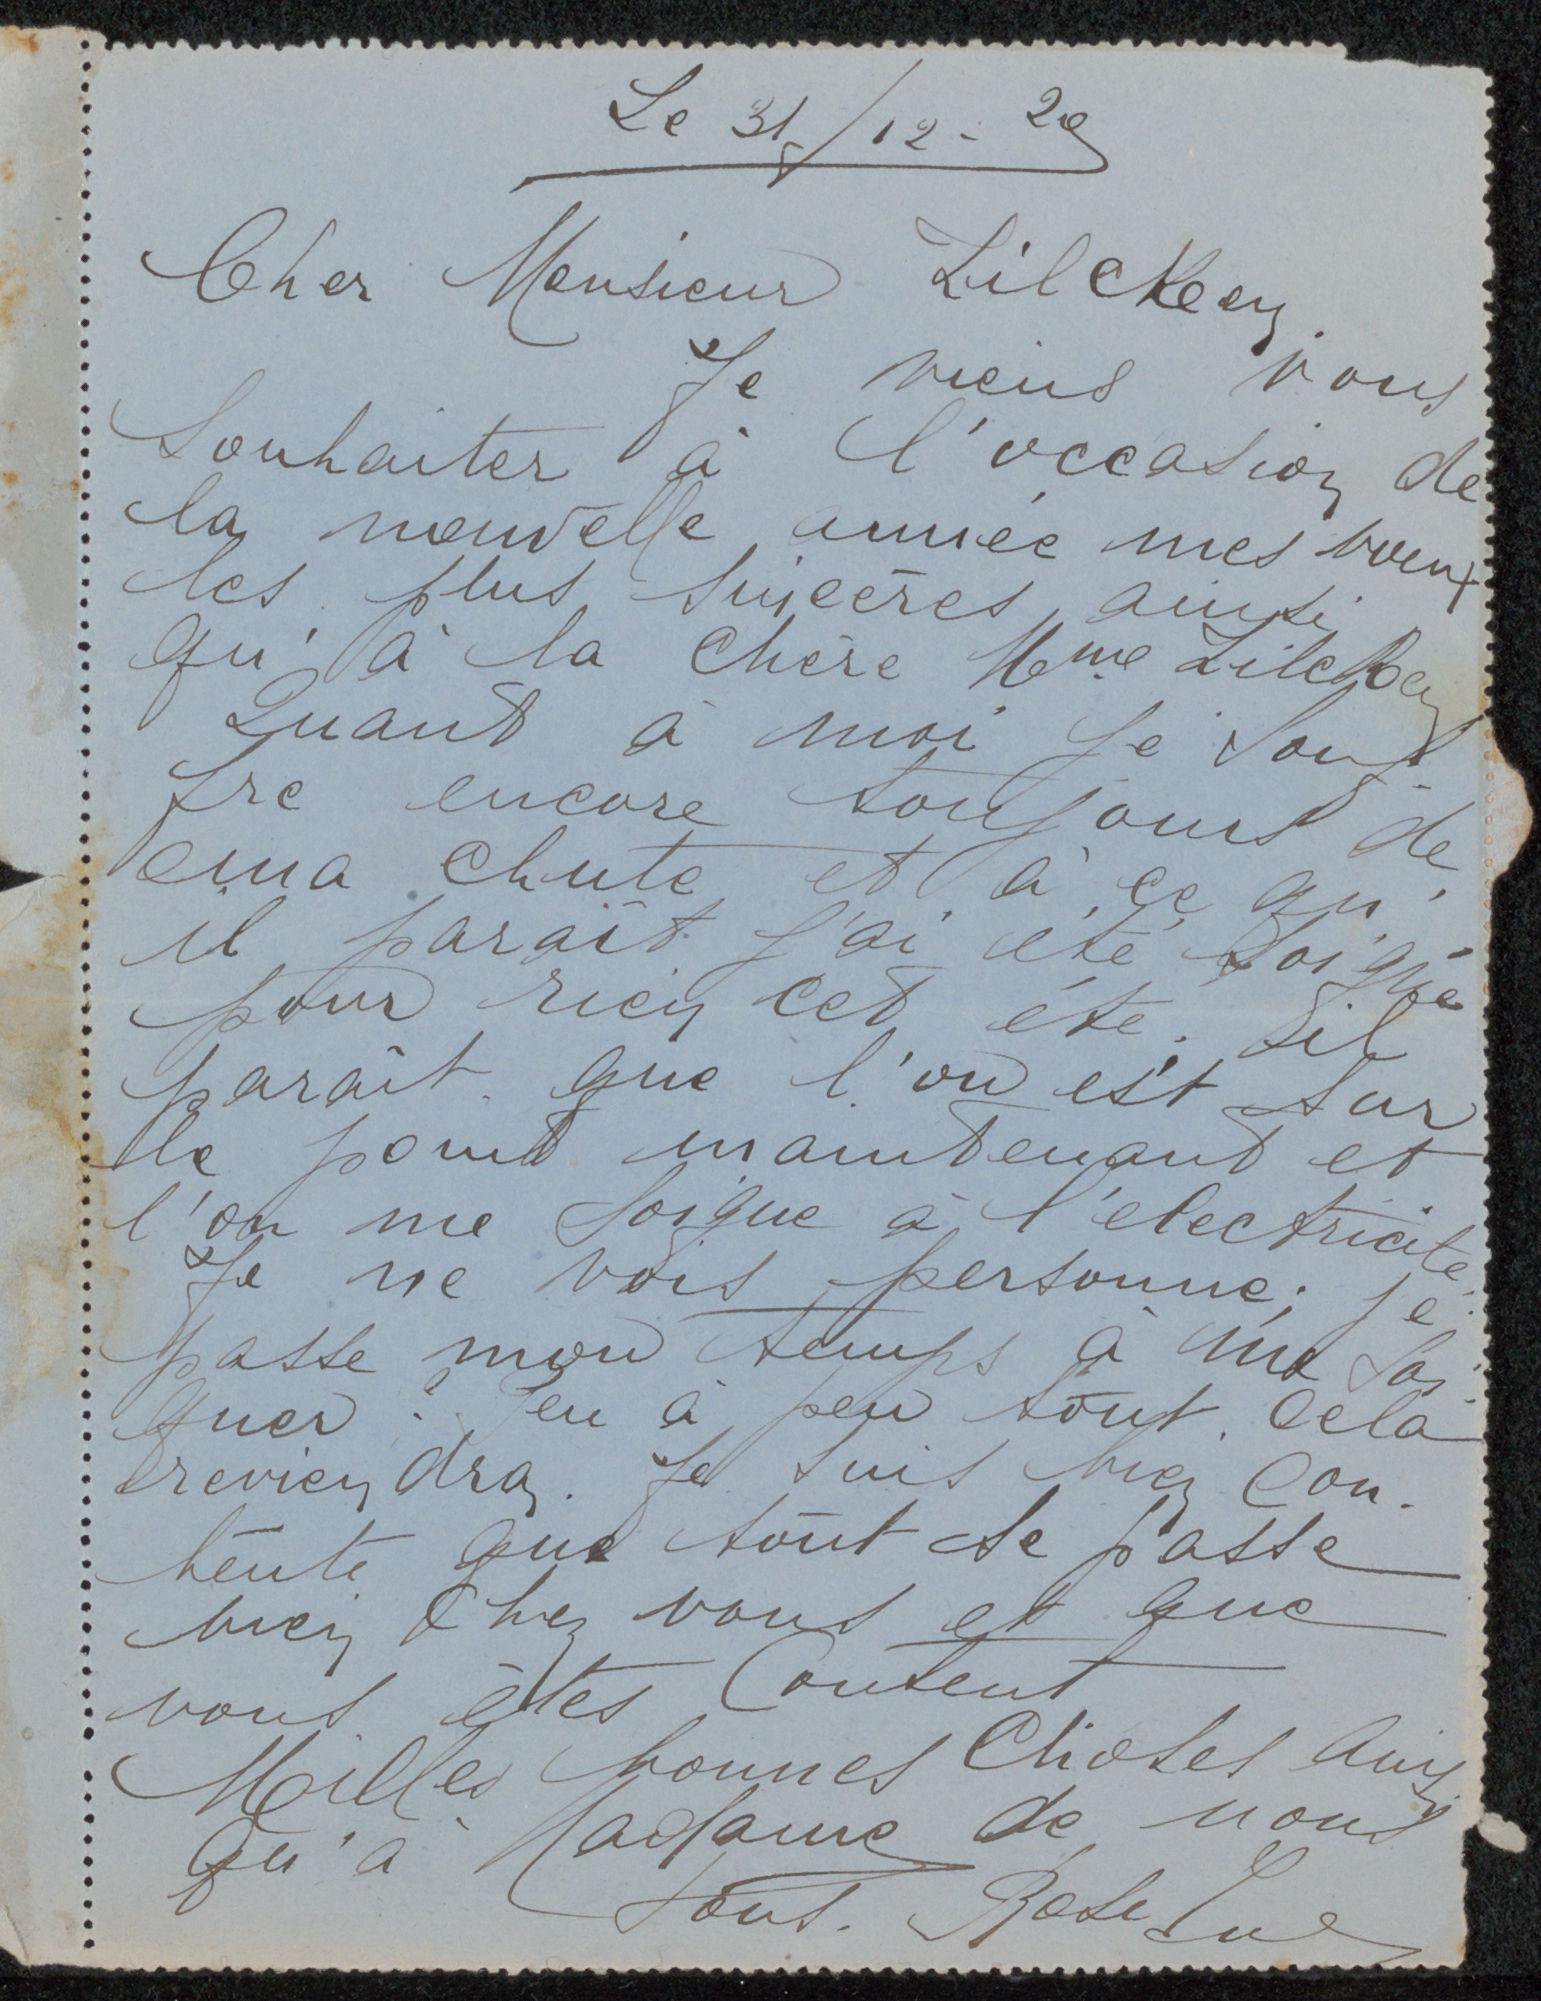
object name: letter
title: Brief aan Philip Zilcken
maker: rose imel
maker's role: draughtsman, painter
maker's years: 1901-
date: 1923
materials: ink, paper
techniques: pen, printing, writing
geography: paris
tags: the hague, painter, draughtsman, philip zilcken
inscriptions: collector's mark: ‘RPK’